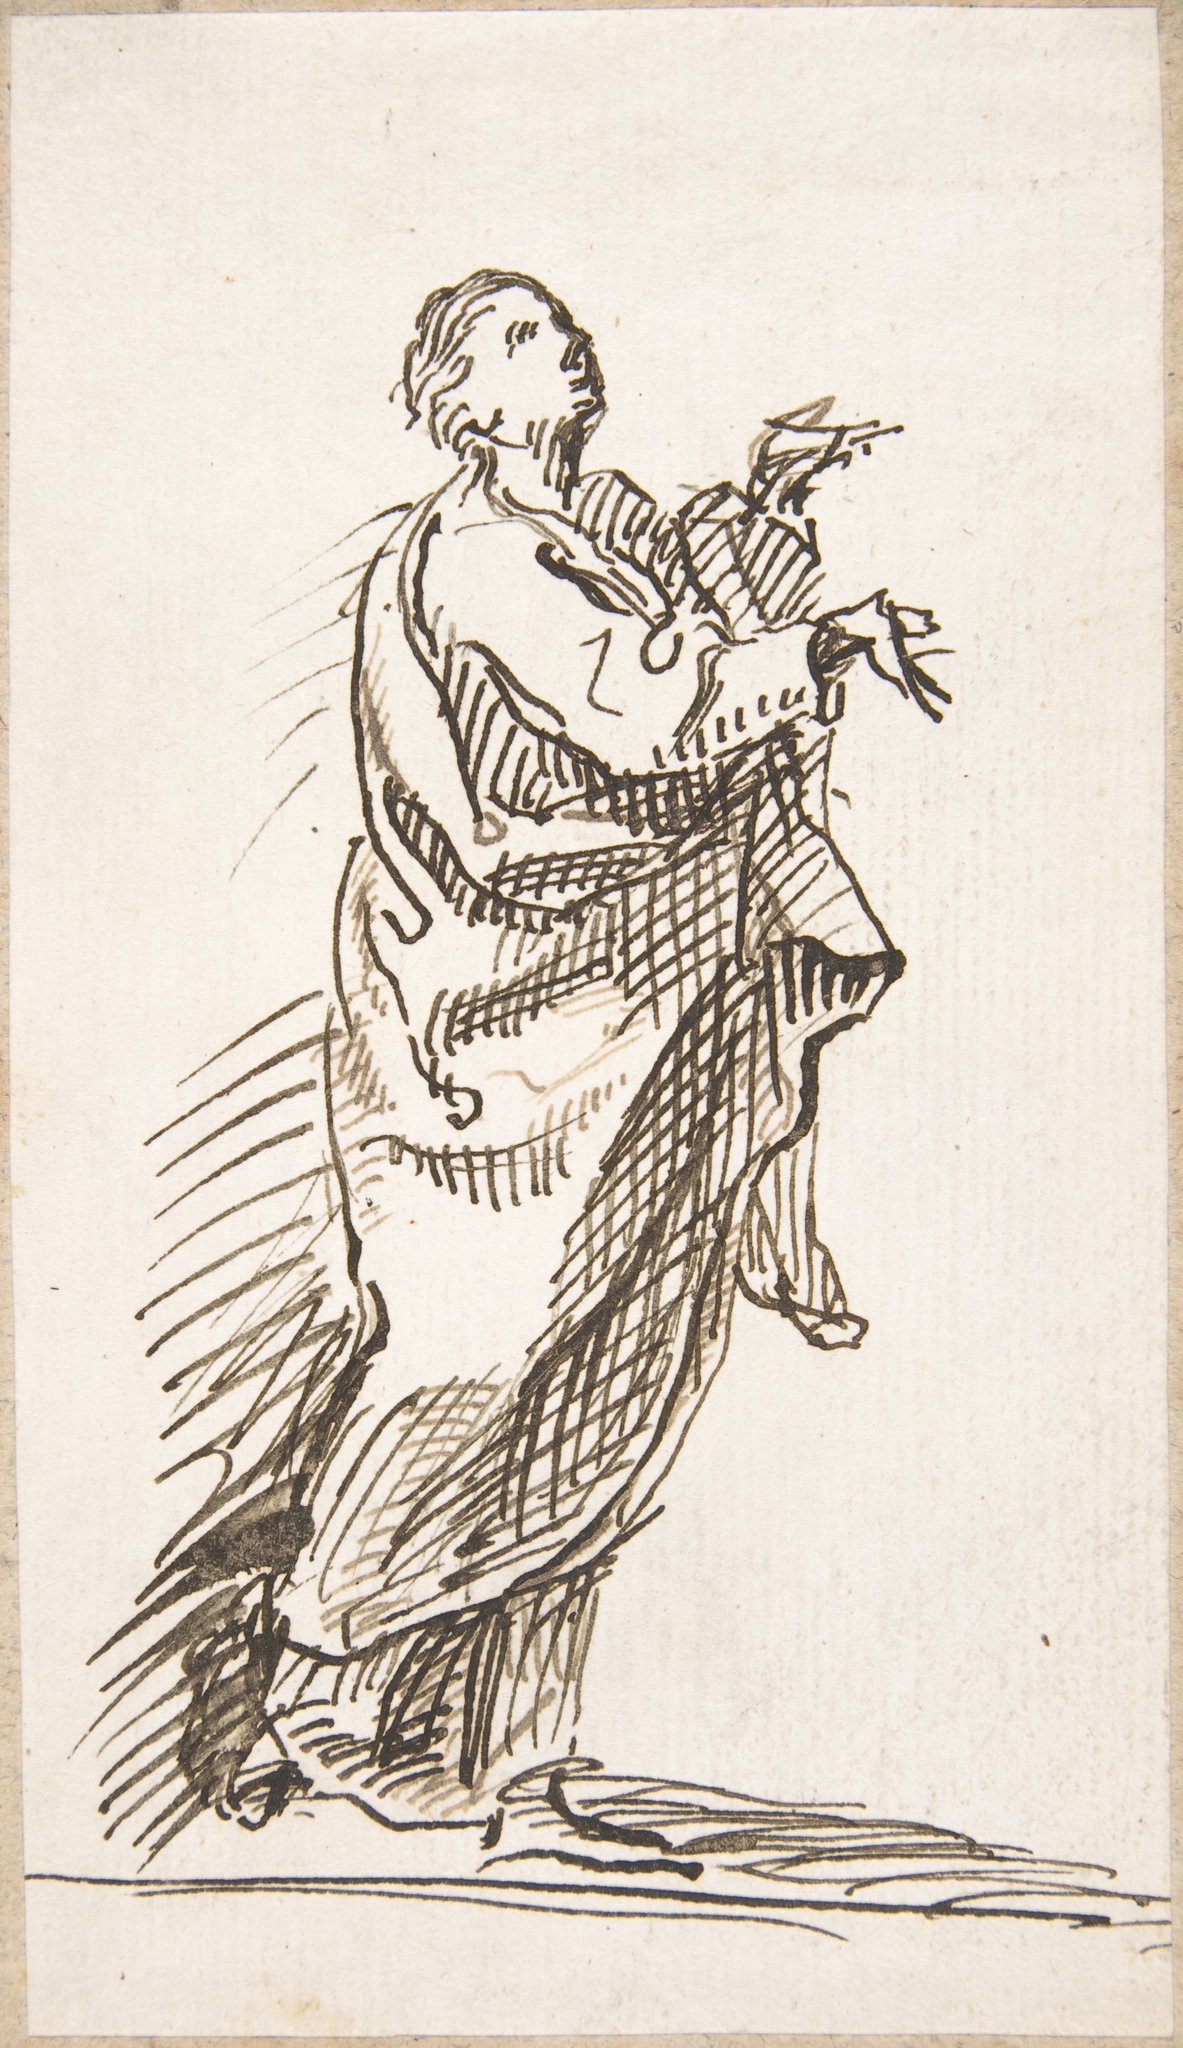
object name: drawing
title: Standing Saint (Apostle?)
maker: pedro duque cornejo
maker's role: artist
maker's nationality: spanish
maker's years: 1677-1757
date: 1700-1750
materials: ink, ivory, paper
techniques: pen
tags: men